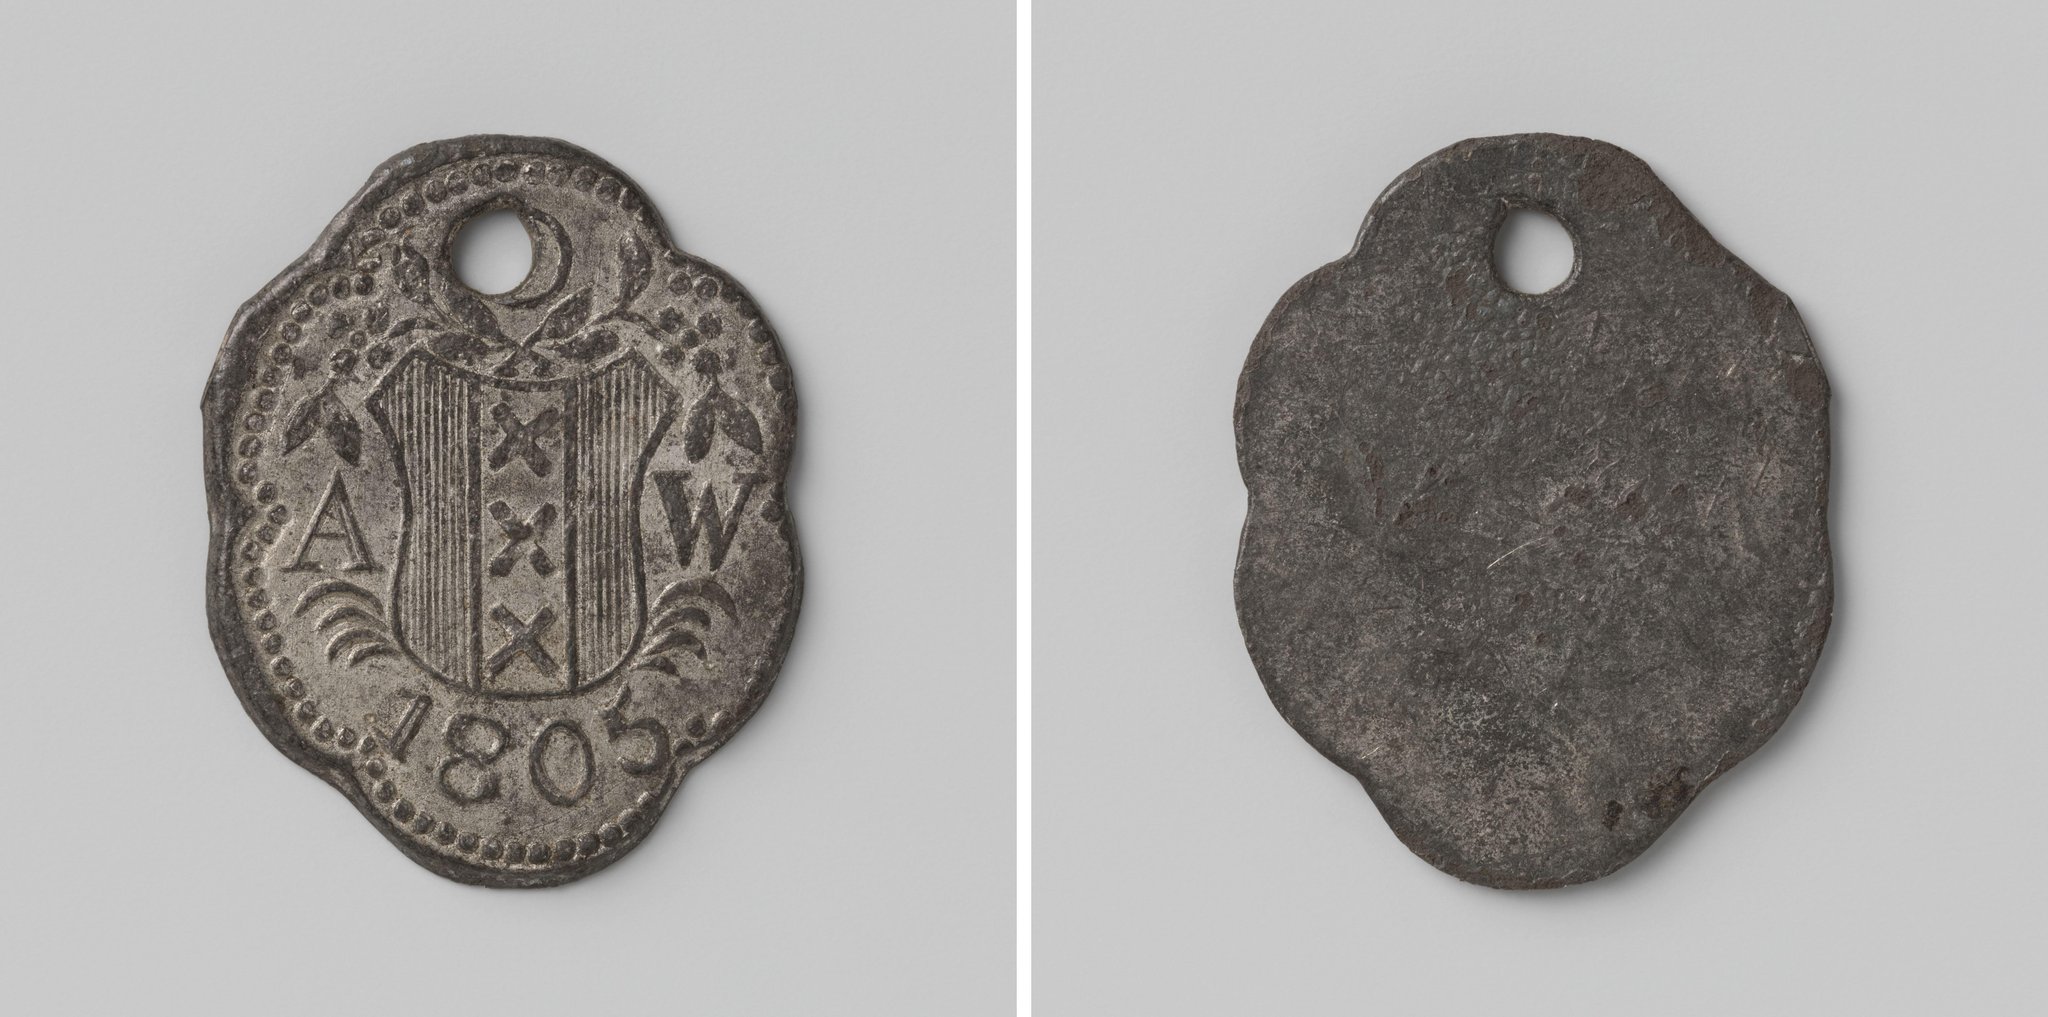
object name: tax token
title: Aalmoezeniersweeshuis te Amsterdam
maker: Anonymous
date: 1805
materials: tin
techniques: striking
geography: amsterdam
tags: amsterdam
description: eenzijdig, zeslobbig loodje met gat erin. Voorzijde: wapenschild, omgeven door bladertakjes tussen opschrift AW boven jaartal. Keerzijde: blanco